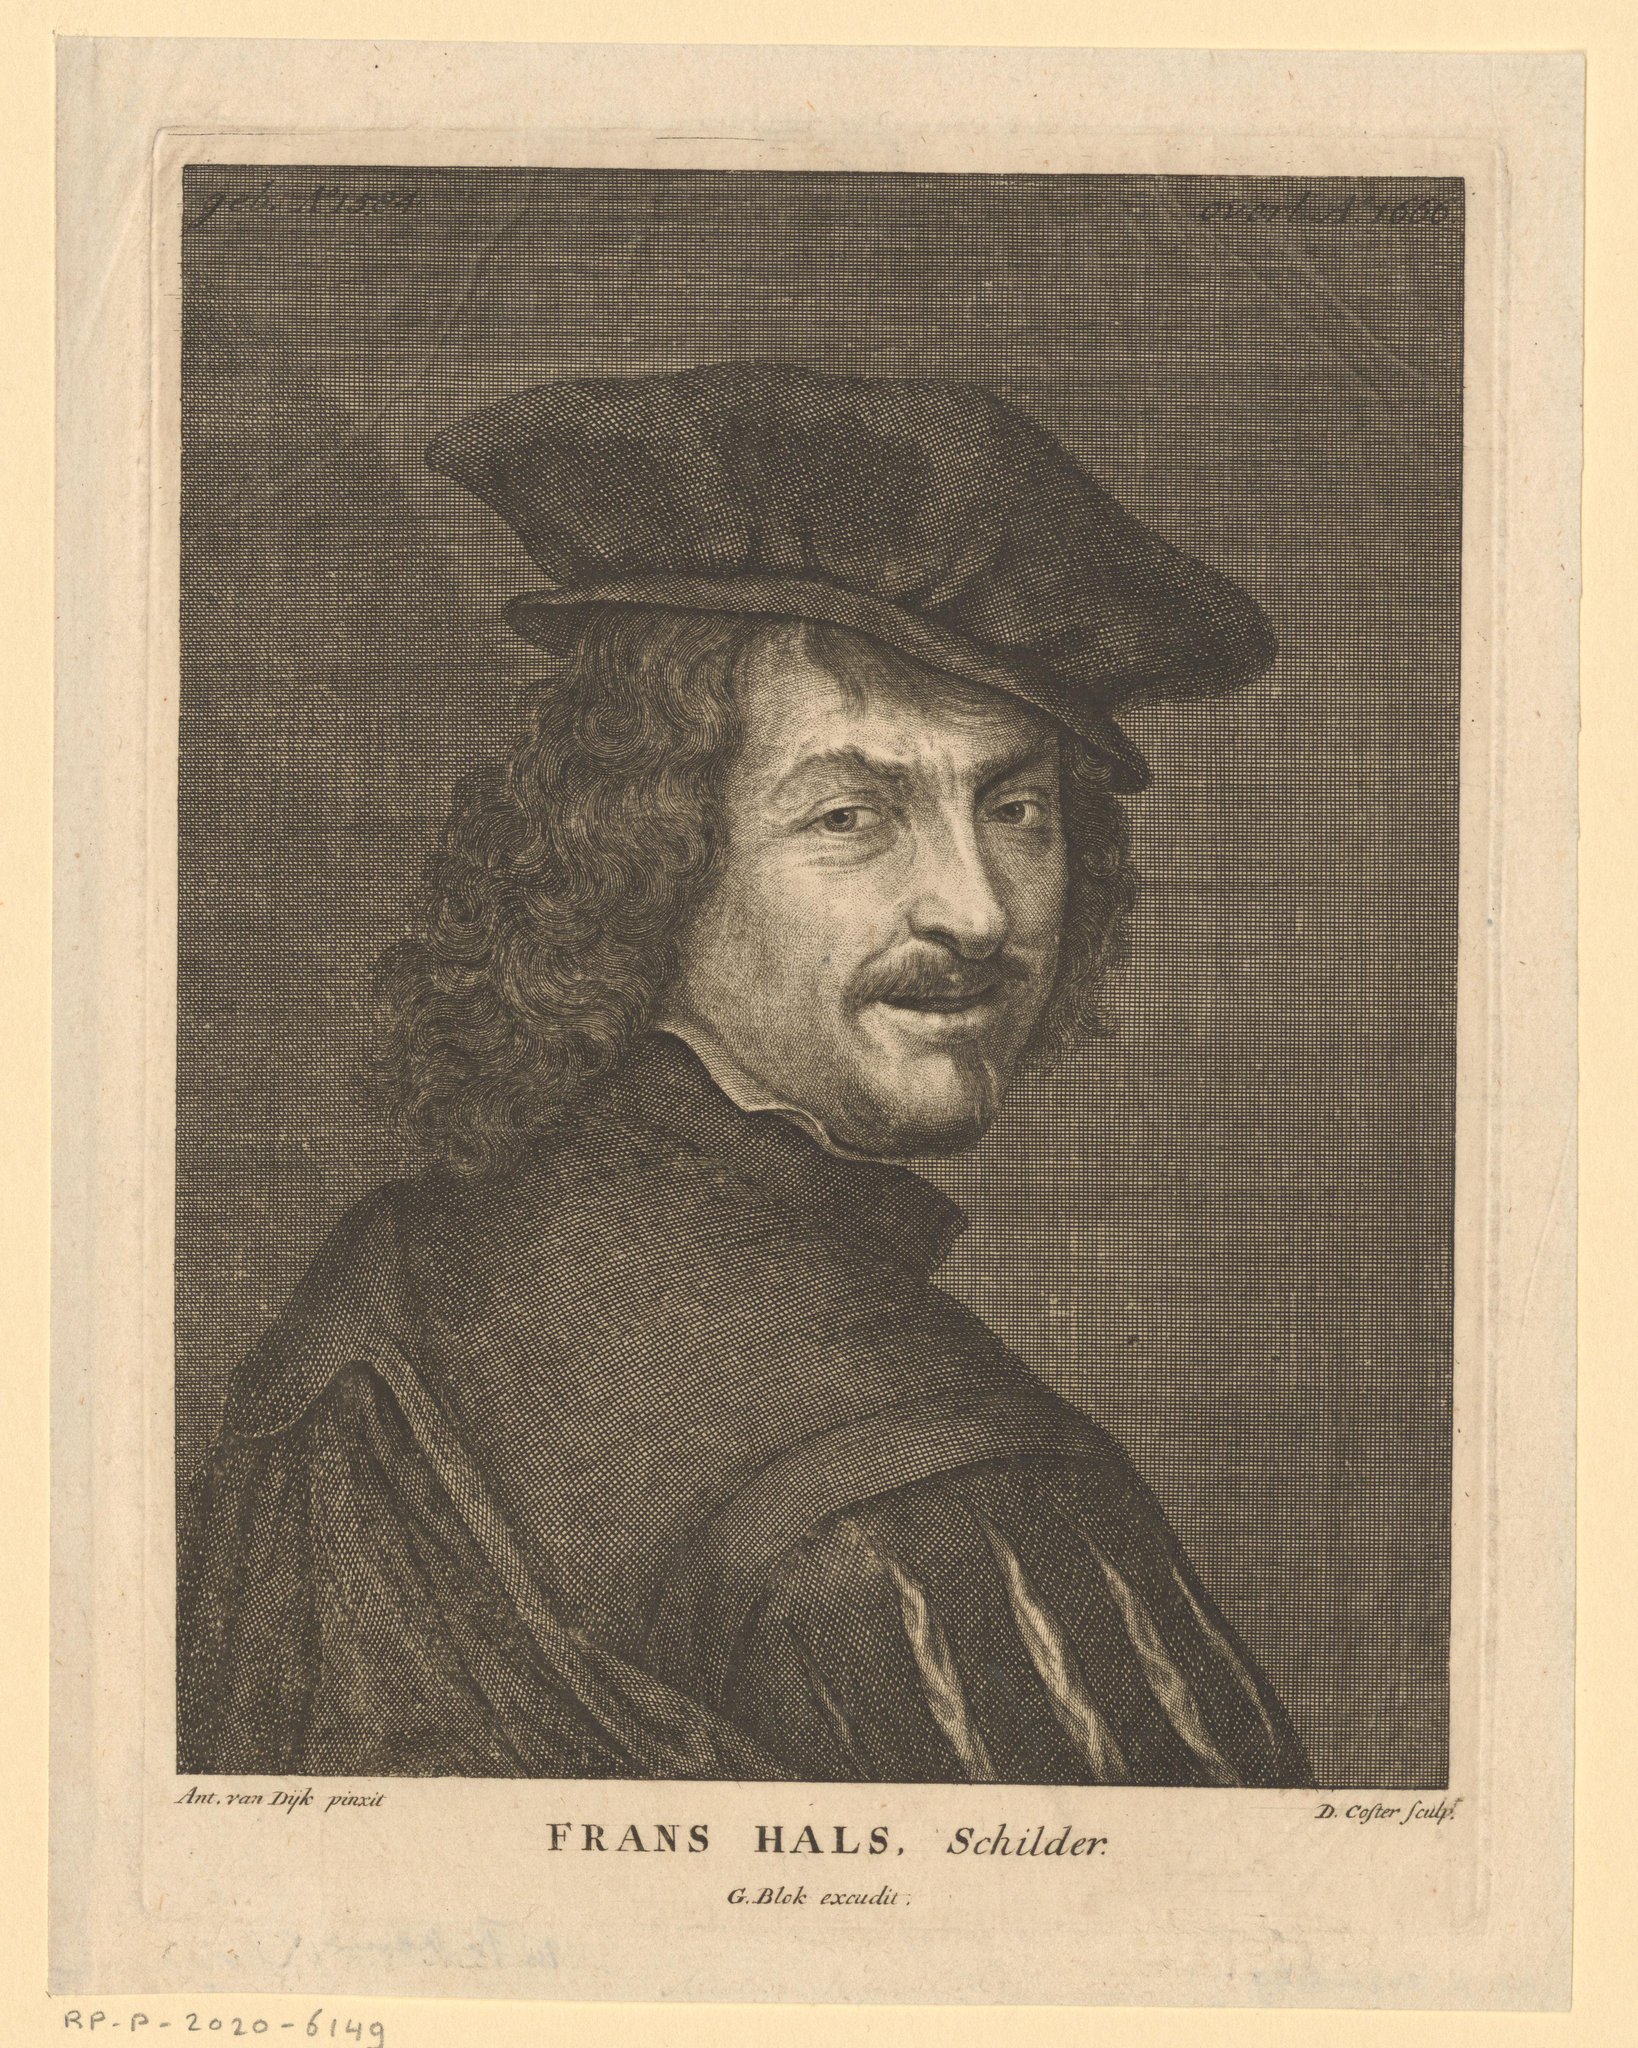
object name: print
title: Portret van Frans Hals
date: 1732-1743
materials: paper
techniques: engraving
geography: the hague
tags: antwerp, haarlem, draughtsman, frans hals, historical persons, portrait, self-portrait of painter